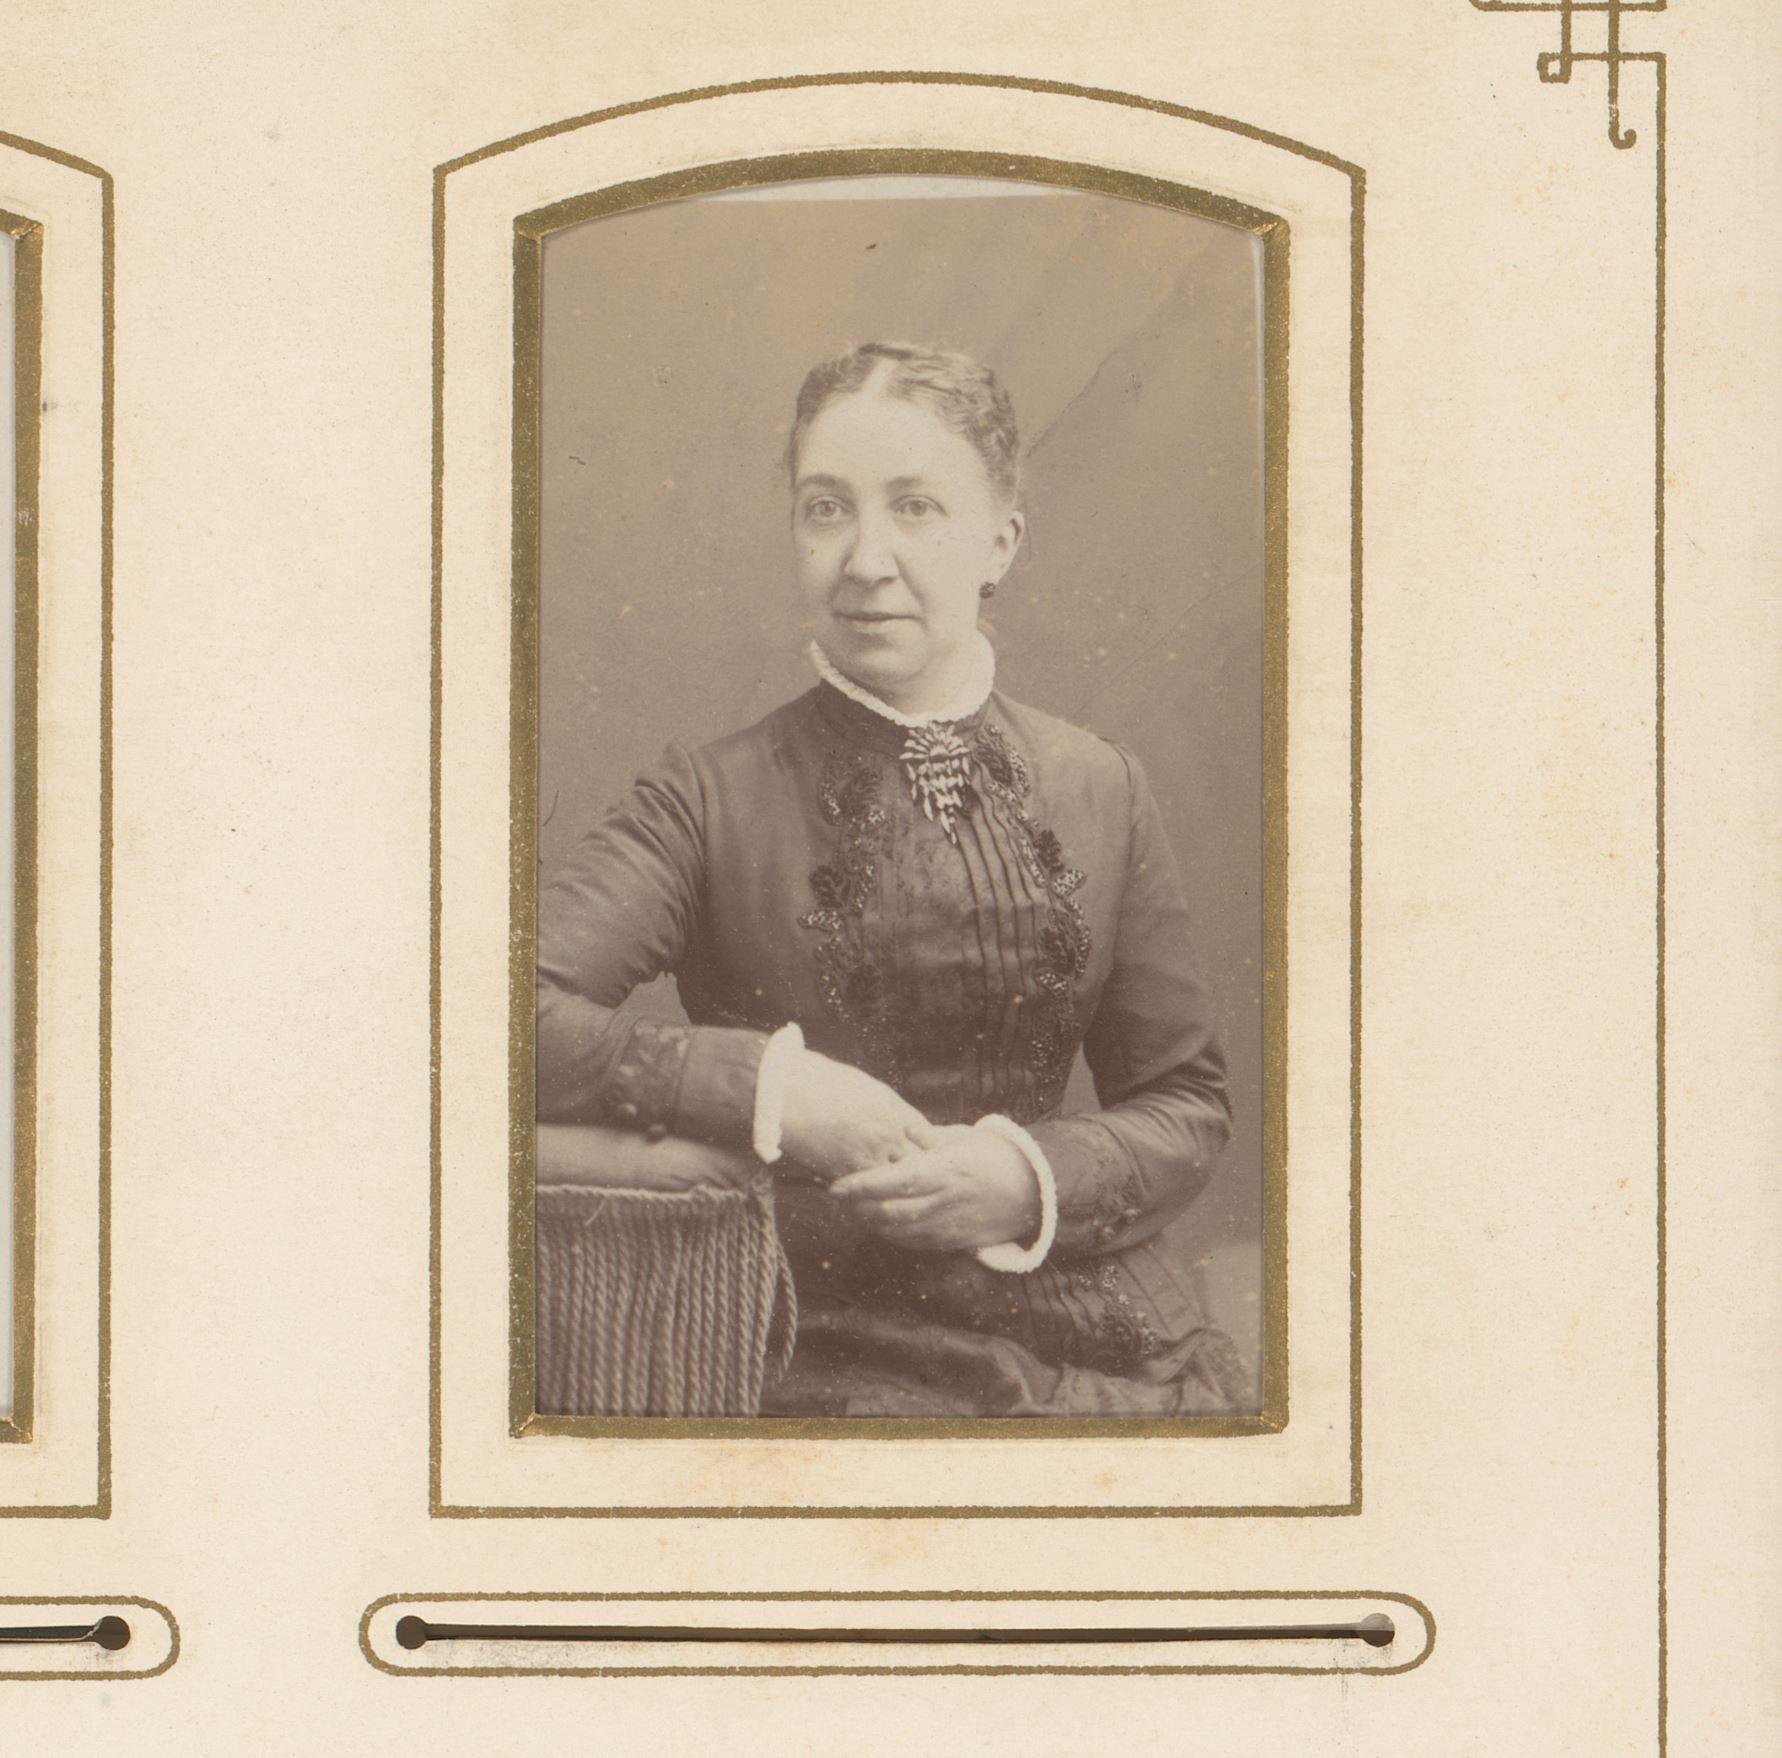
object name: carte de visite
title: Portret van een zittende vrouw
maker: idanus hendrikus slaterus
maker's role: fotograaf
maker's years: 1846-1921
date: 1868-1909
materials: cardboard, photographic support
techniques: albumen print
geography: leeuwarden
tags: sitting figure - aa - female human figure, historical persons - bb - woman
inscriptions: inscription: ‘Photographie/ I. H. Slaterus/ Leeuwarden/ Weerd K. 13,/ hoek Bagÿnestraat.’